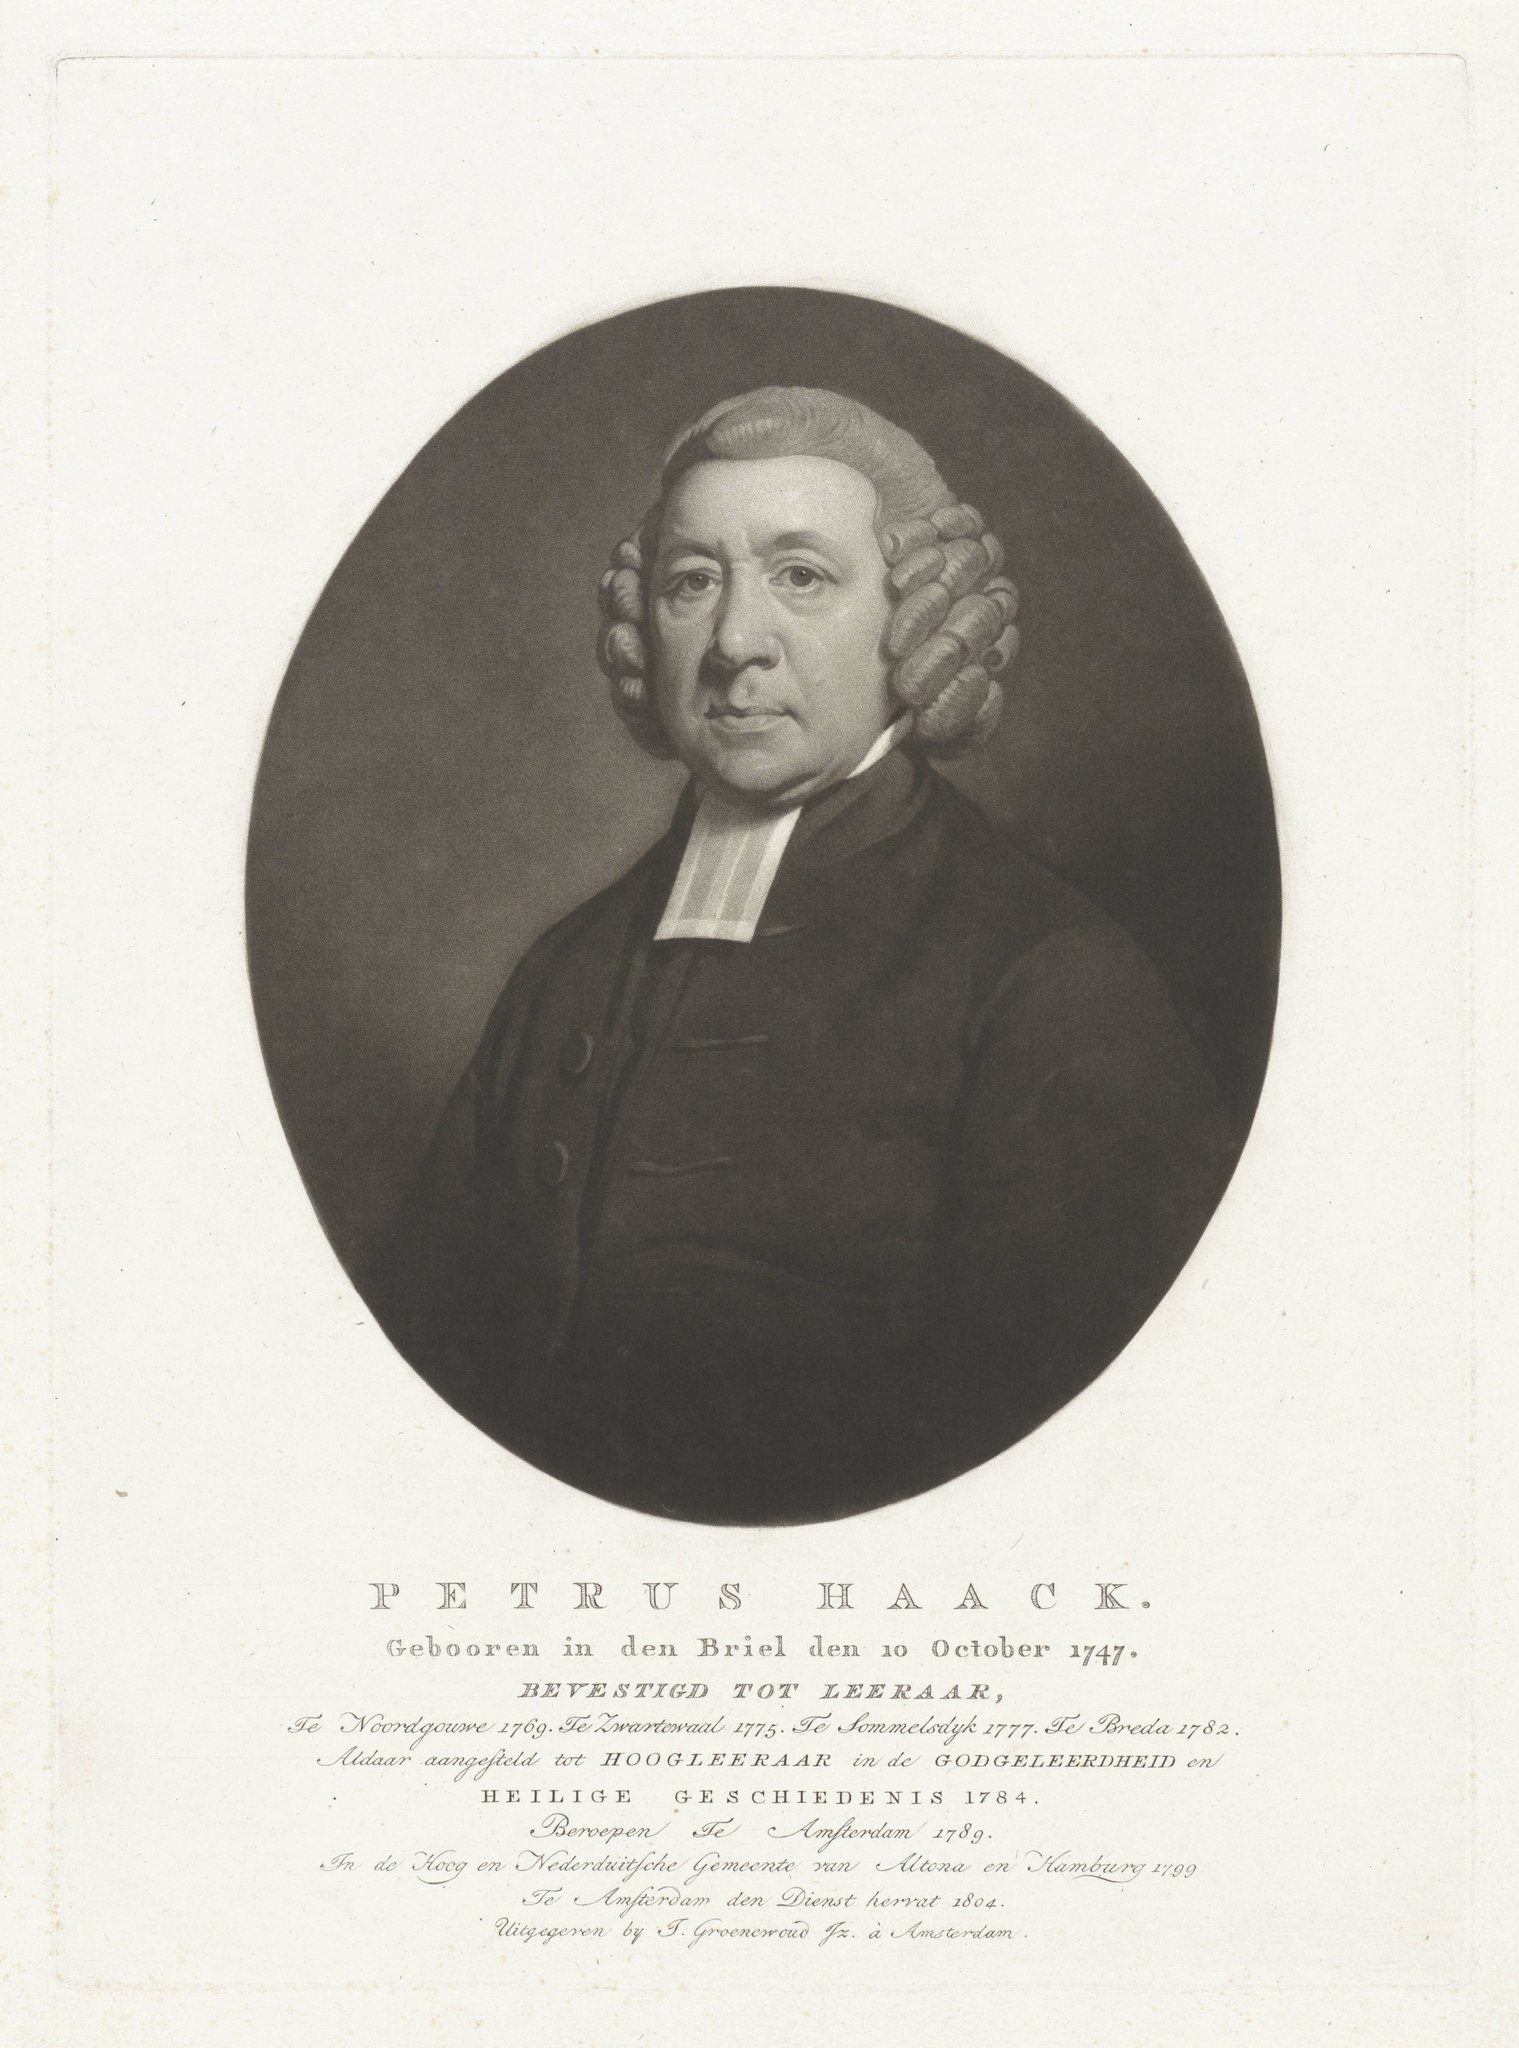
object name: print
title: Portret van de predikant Petrus Haack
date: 1804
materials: paper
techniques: mezzotint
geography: amsterdam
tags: brielle, amsterdam, petrus haack, wig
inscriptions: collector's mark: Lugt 2228